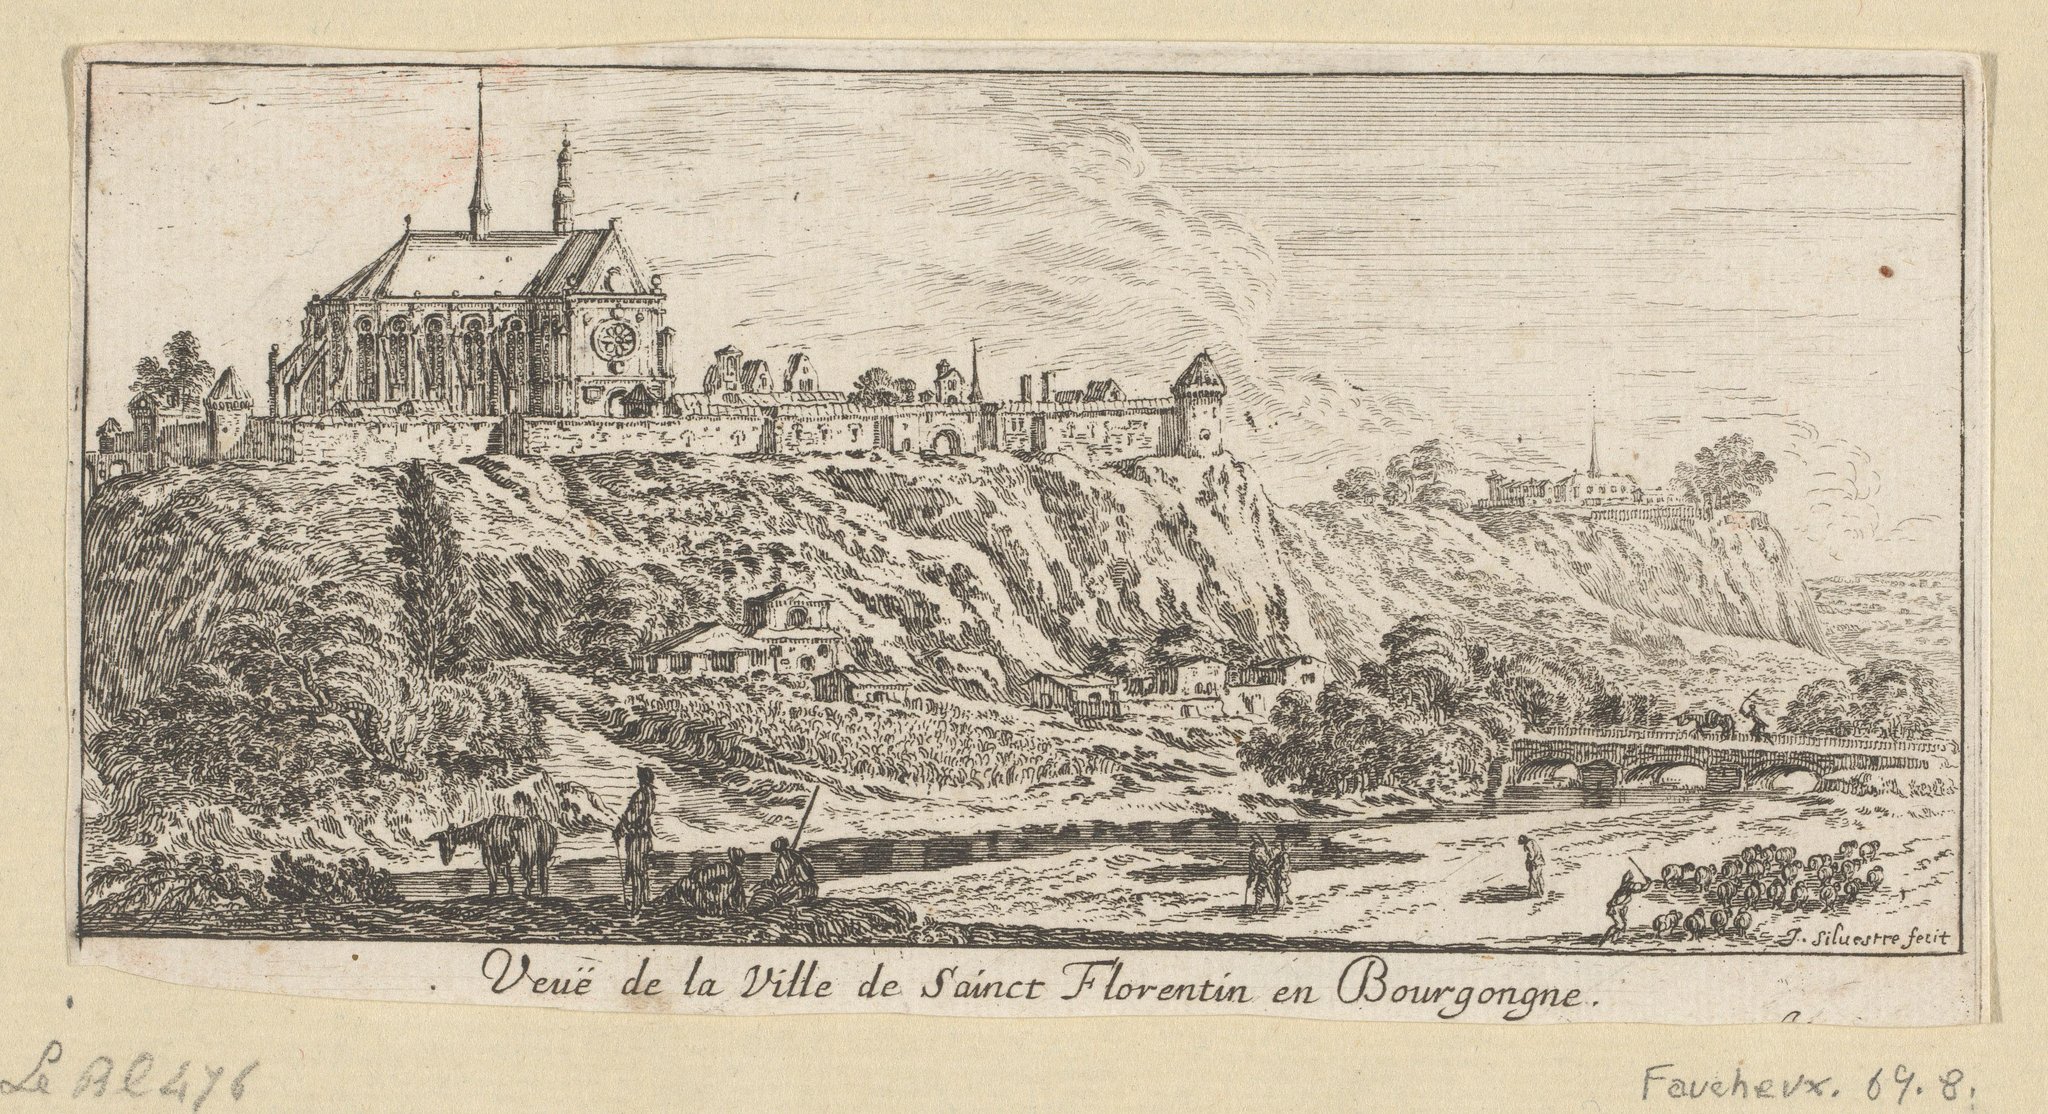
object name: print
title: Divers Paisages sur le naturel de la Duché de Bourgogne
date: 1650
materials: paper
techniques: etching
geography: paris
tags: prospect of village, silhouette of village, building of church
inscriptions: collector's mark: Lugt 240